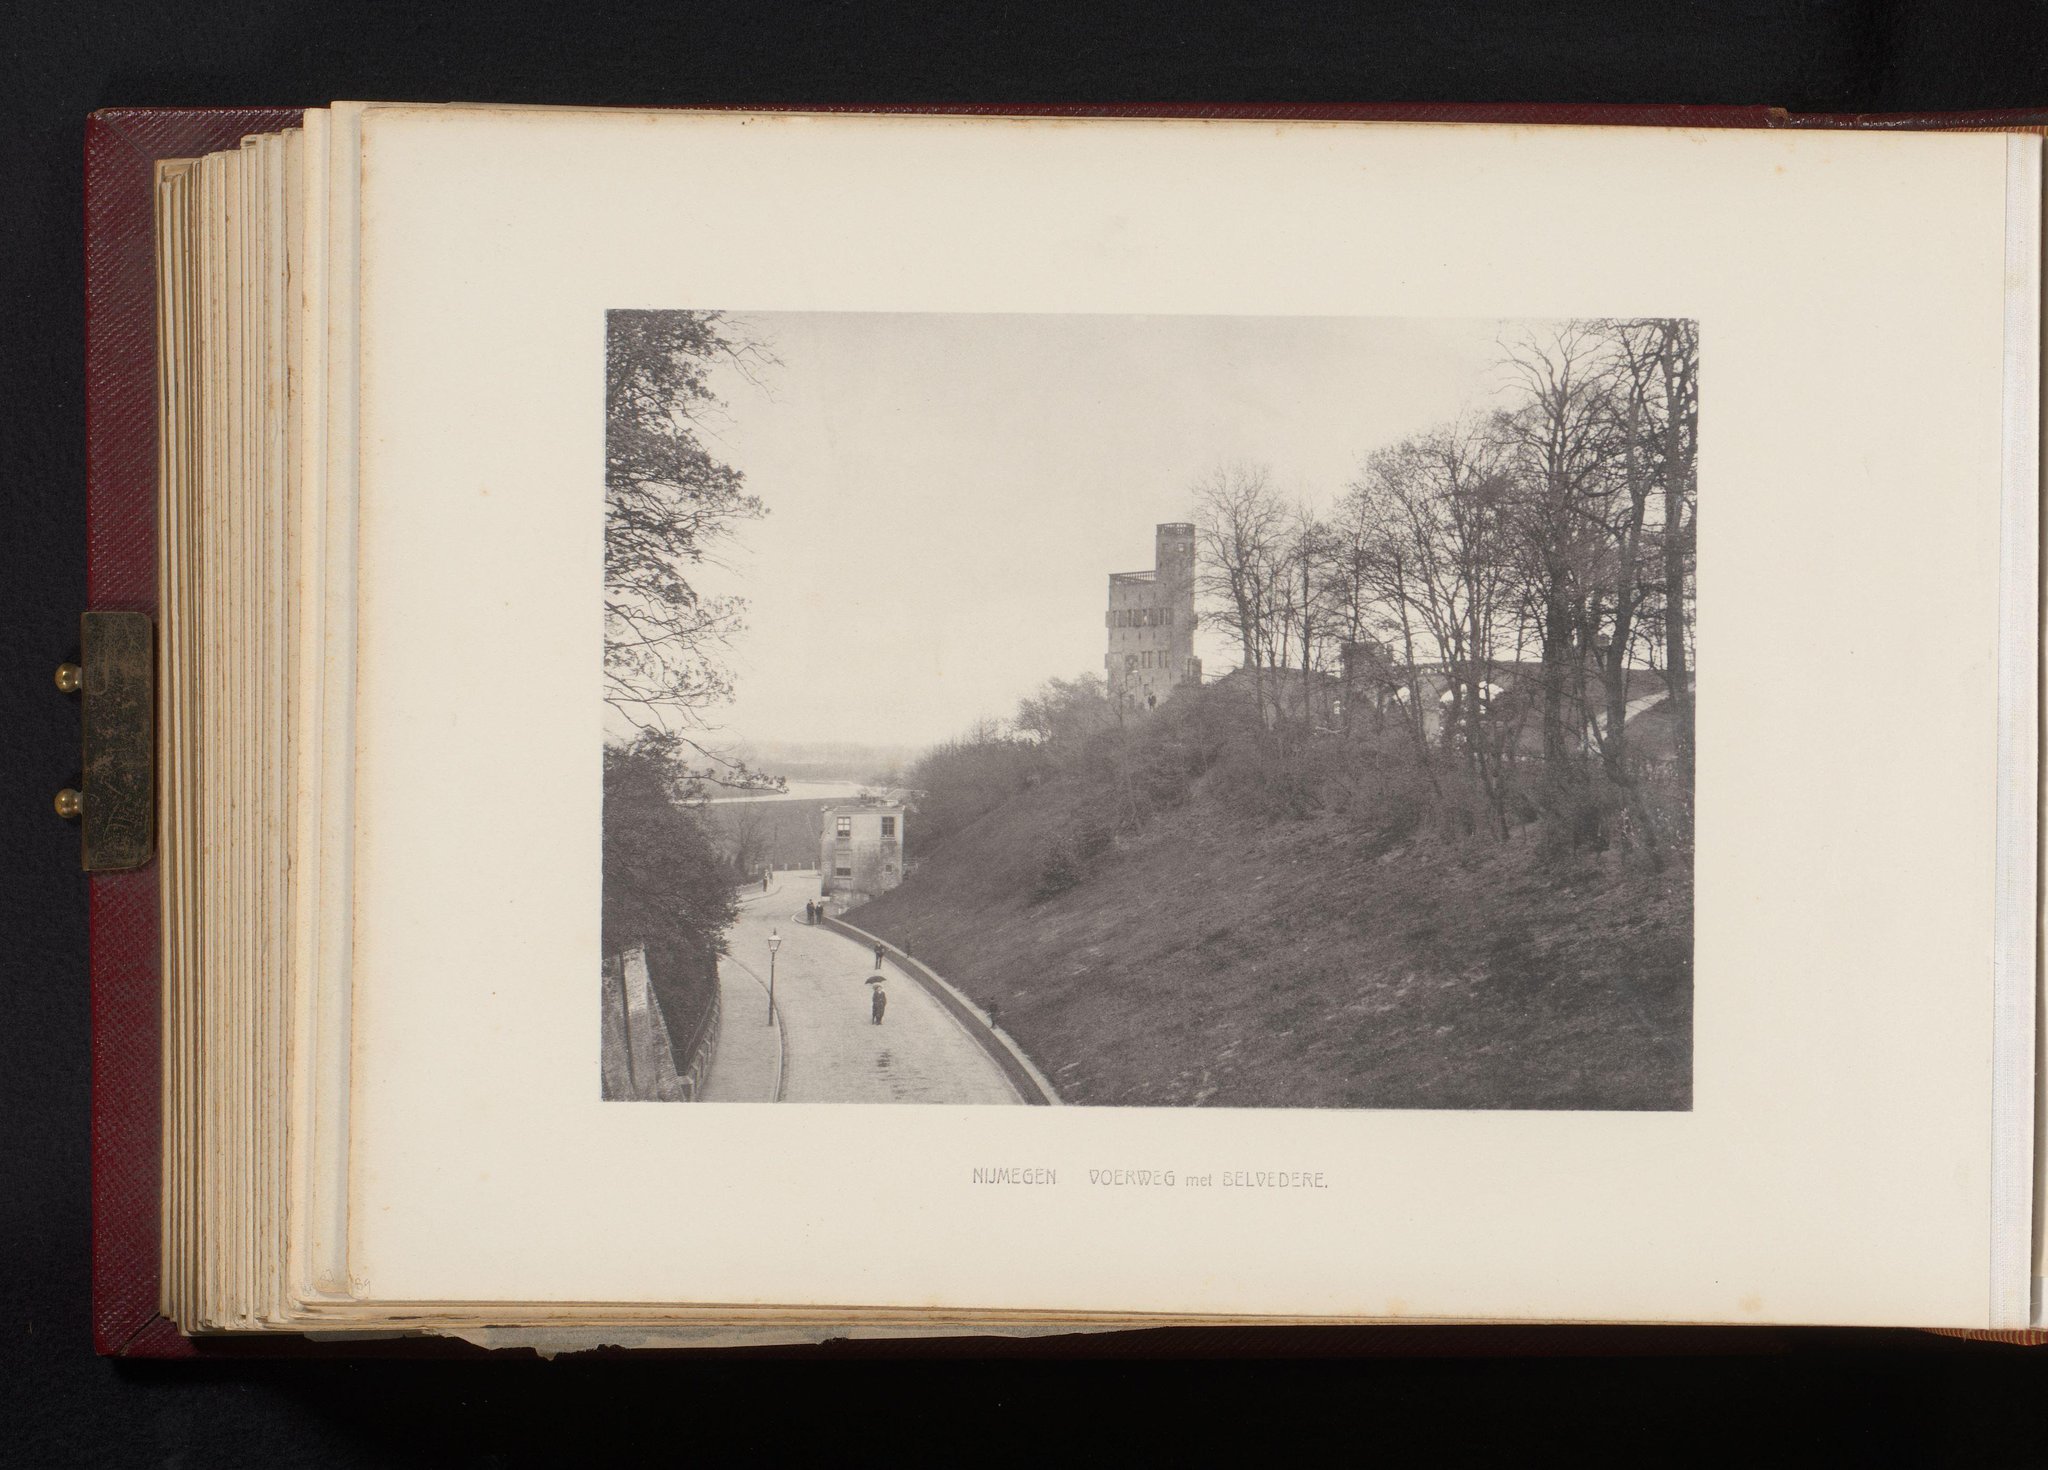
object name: album leaf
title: Voerweg en het Belvédère te Nijmegen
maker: Anonymous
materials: paper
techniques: photograph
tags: towers ~ fortified city, historical persons, road, path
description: Deze pagina maakt deel uit van een album.